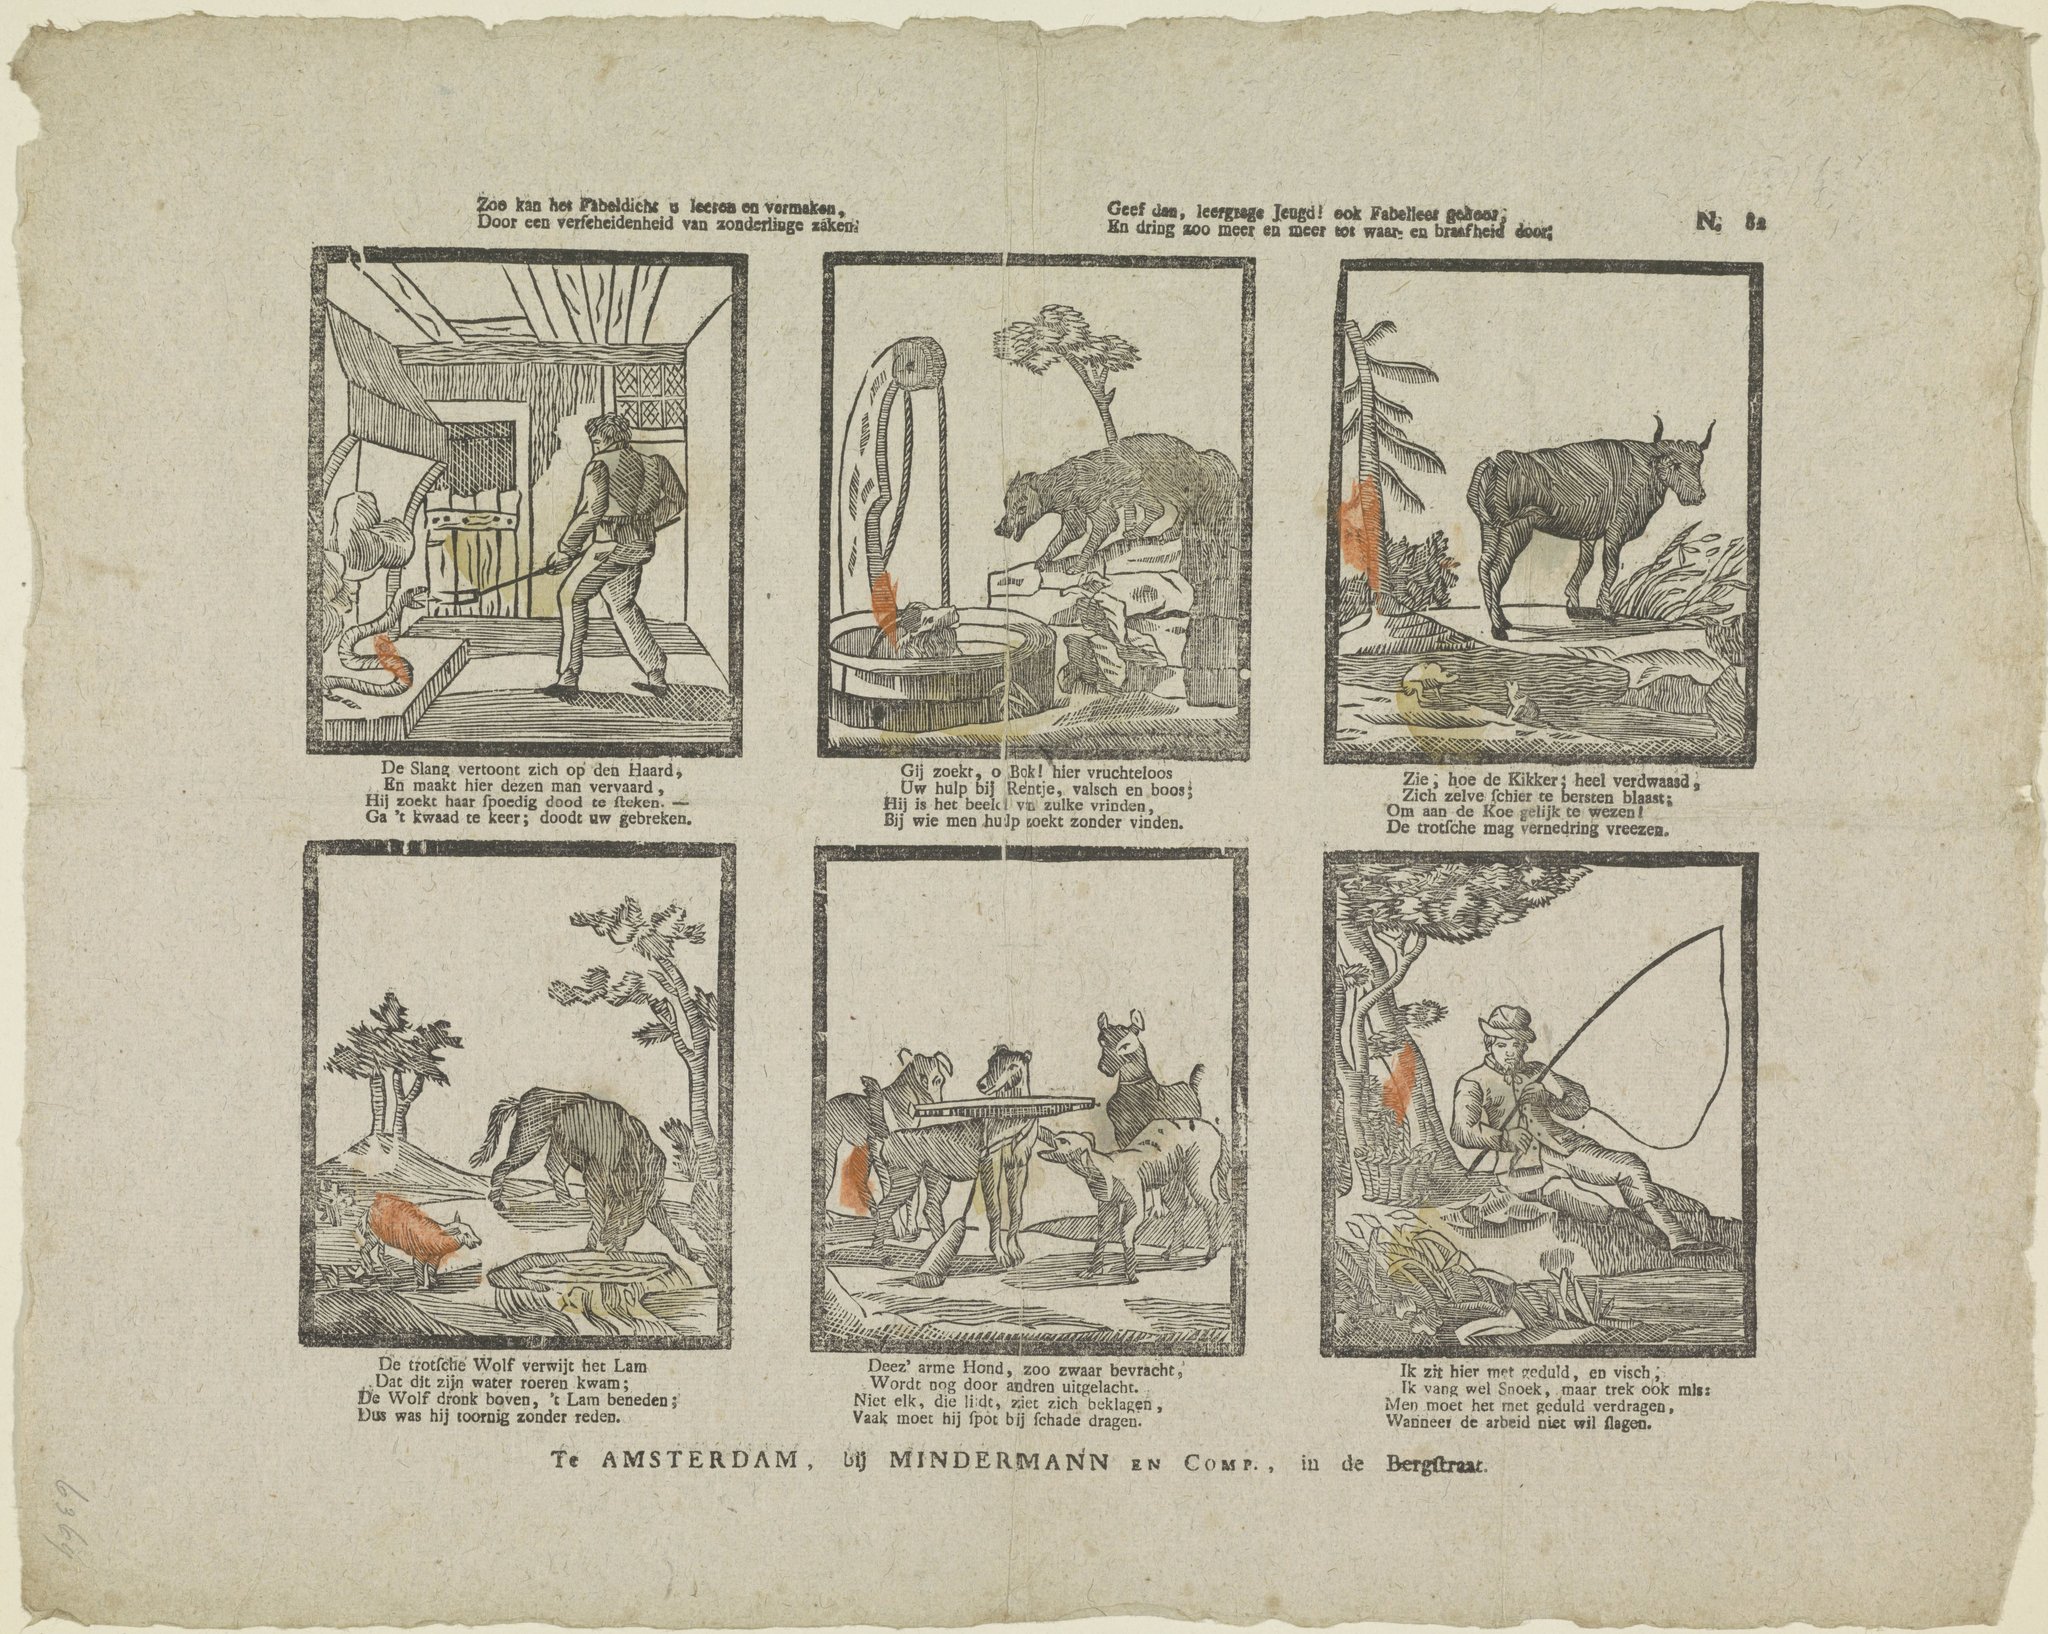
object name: print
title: Zoo kan het fabeldicht u leeren en vermaken, / Door een verscheidenheid van zonderlinge zaken. / Geef dan, leergrage jeugd! ook fabelleer gehoor, / En dring zoo meer en meer tot waar- en braafheid door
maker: Anonymous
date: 1814-1848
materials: paper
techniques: colour, letterpress printing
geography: amsterdam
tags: 'mundus inversus', the reversed world, the topsy-turvy world, 'le monde bestourné', fables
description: Uitgave van nr. 82 uit de fondslijst van Jan de Lange (II) of Jan Hendrik de Lange met het adres van de wederverkoper Erve Wijsmuller.